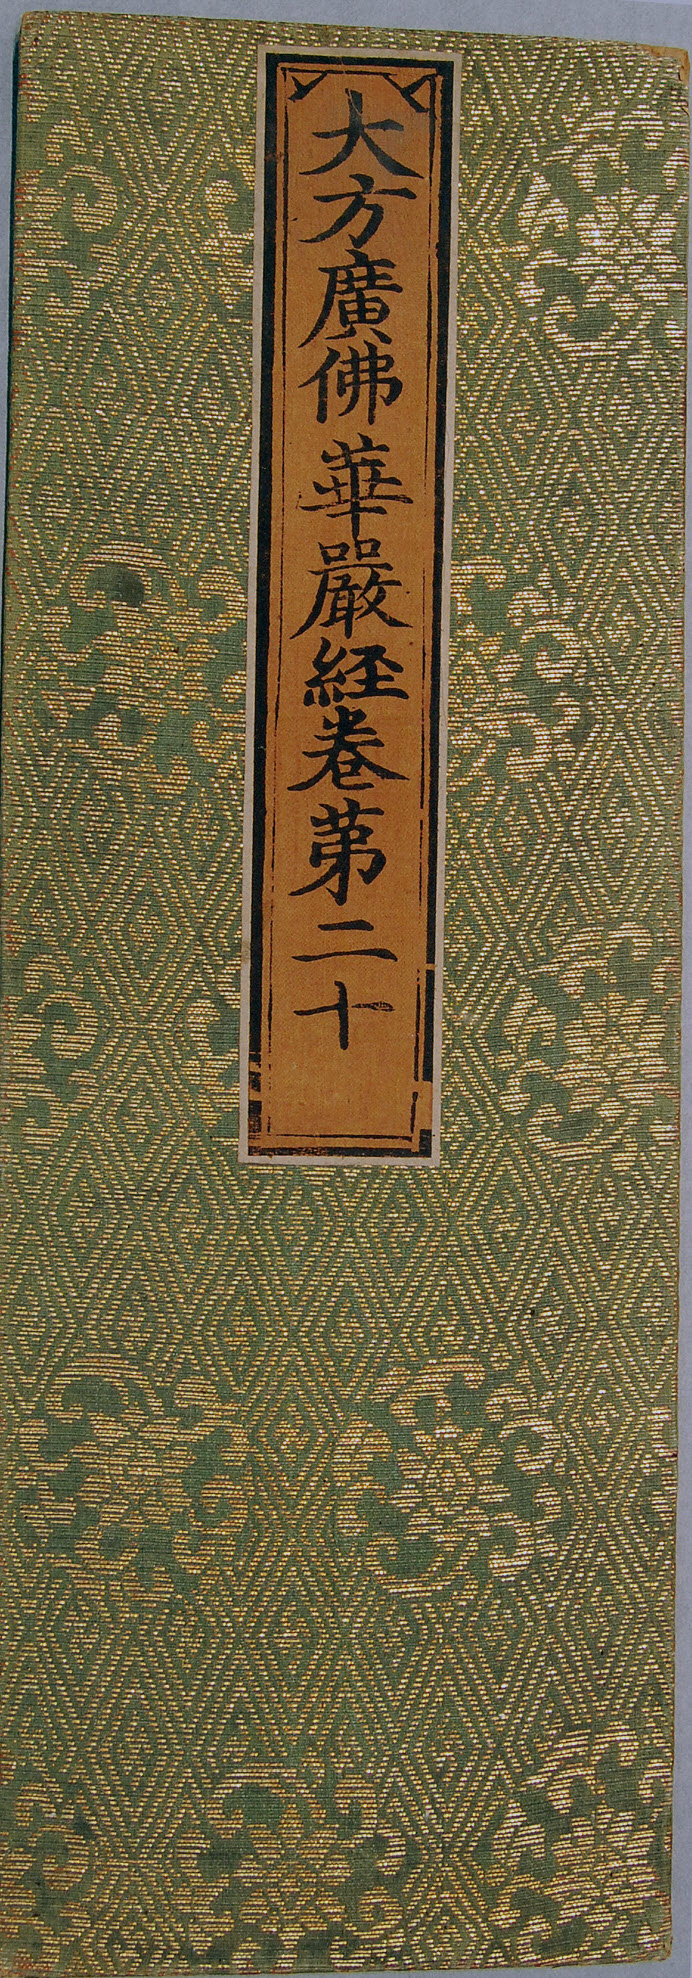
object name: sutra cover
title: Sutra Cover with Floral Roundels on Background Pattern of Lozenges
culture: chinese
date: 1501-1600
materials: metal thread, silk